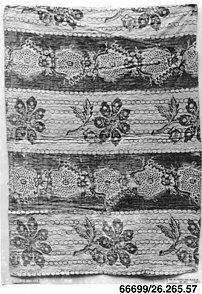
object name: floral print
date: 1788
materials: linen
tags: flowers